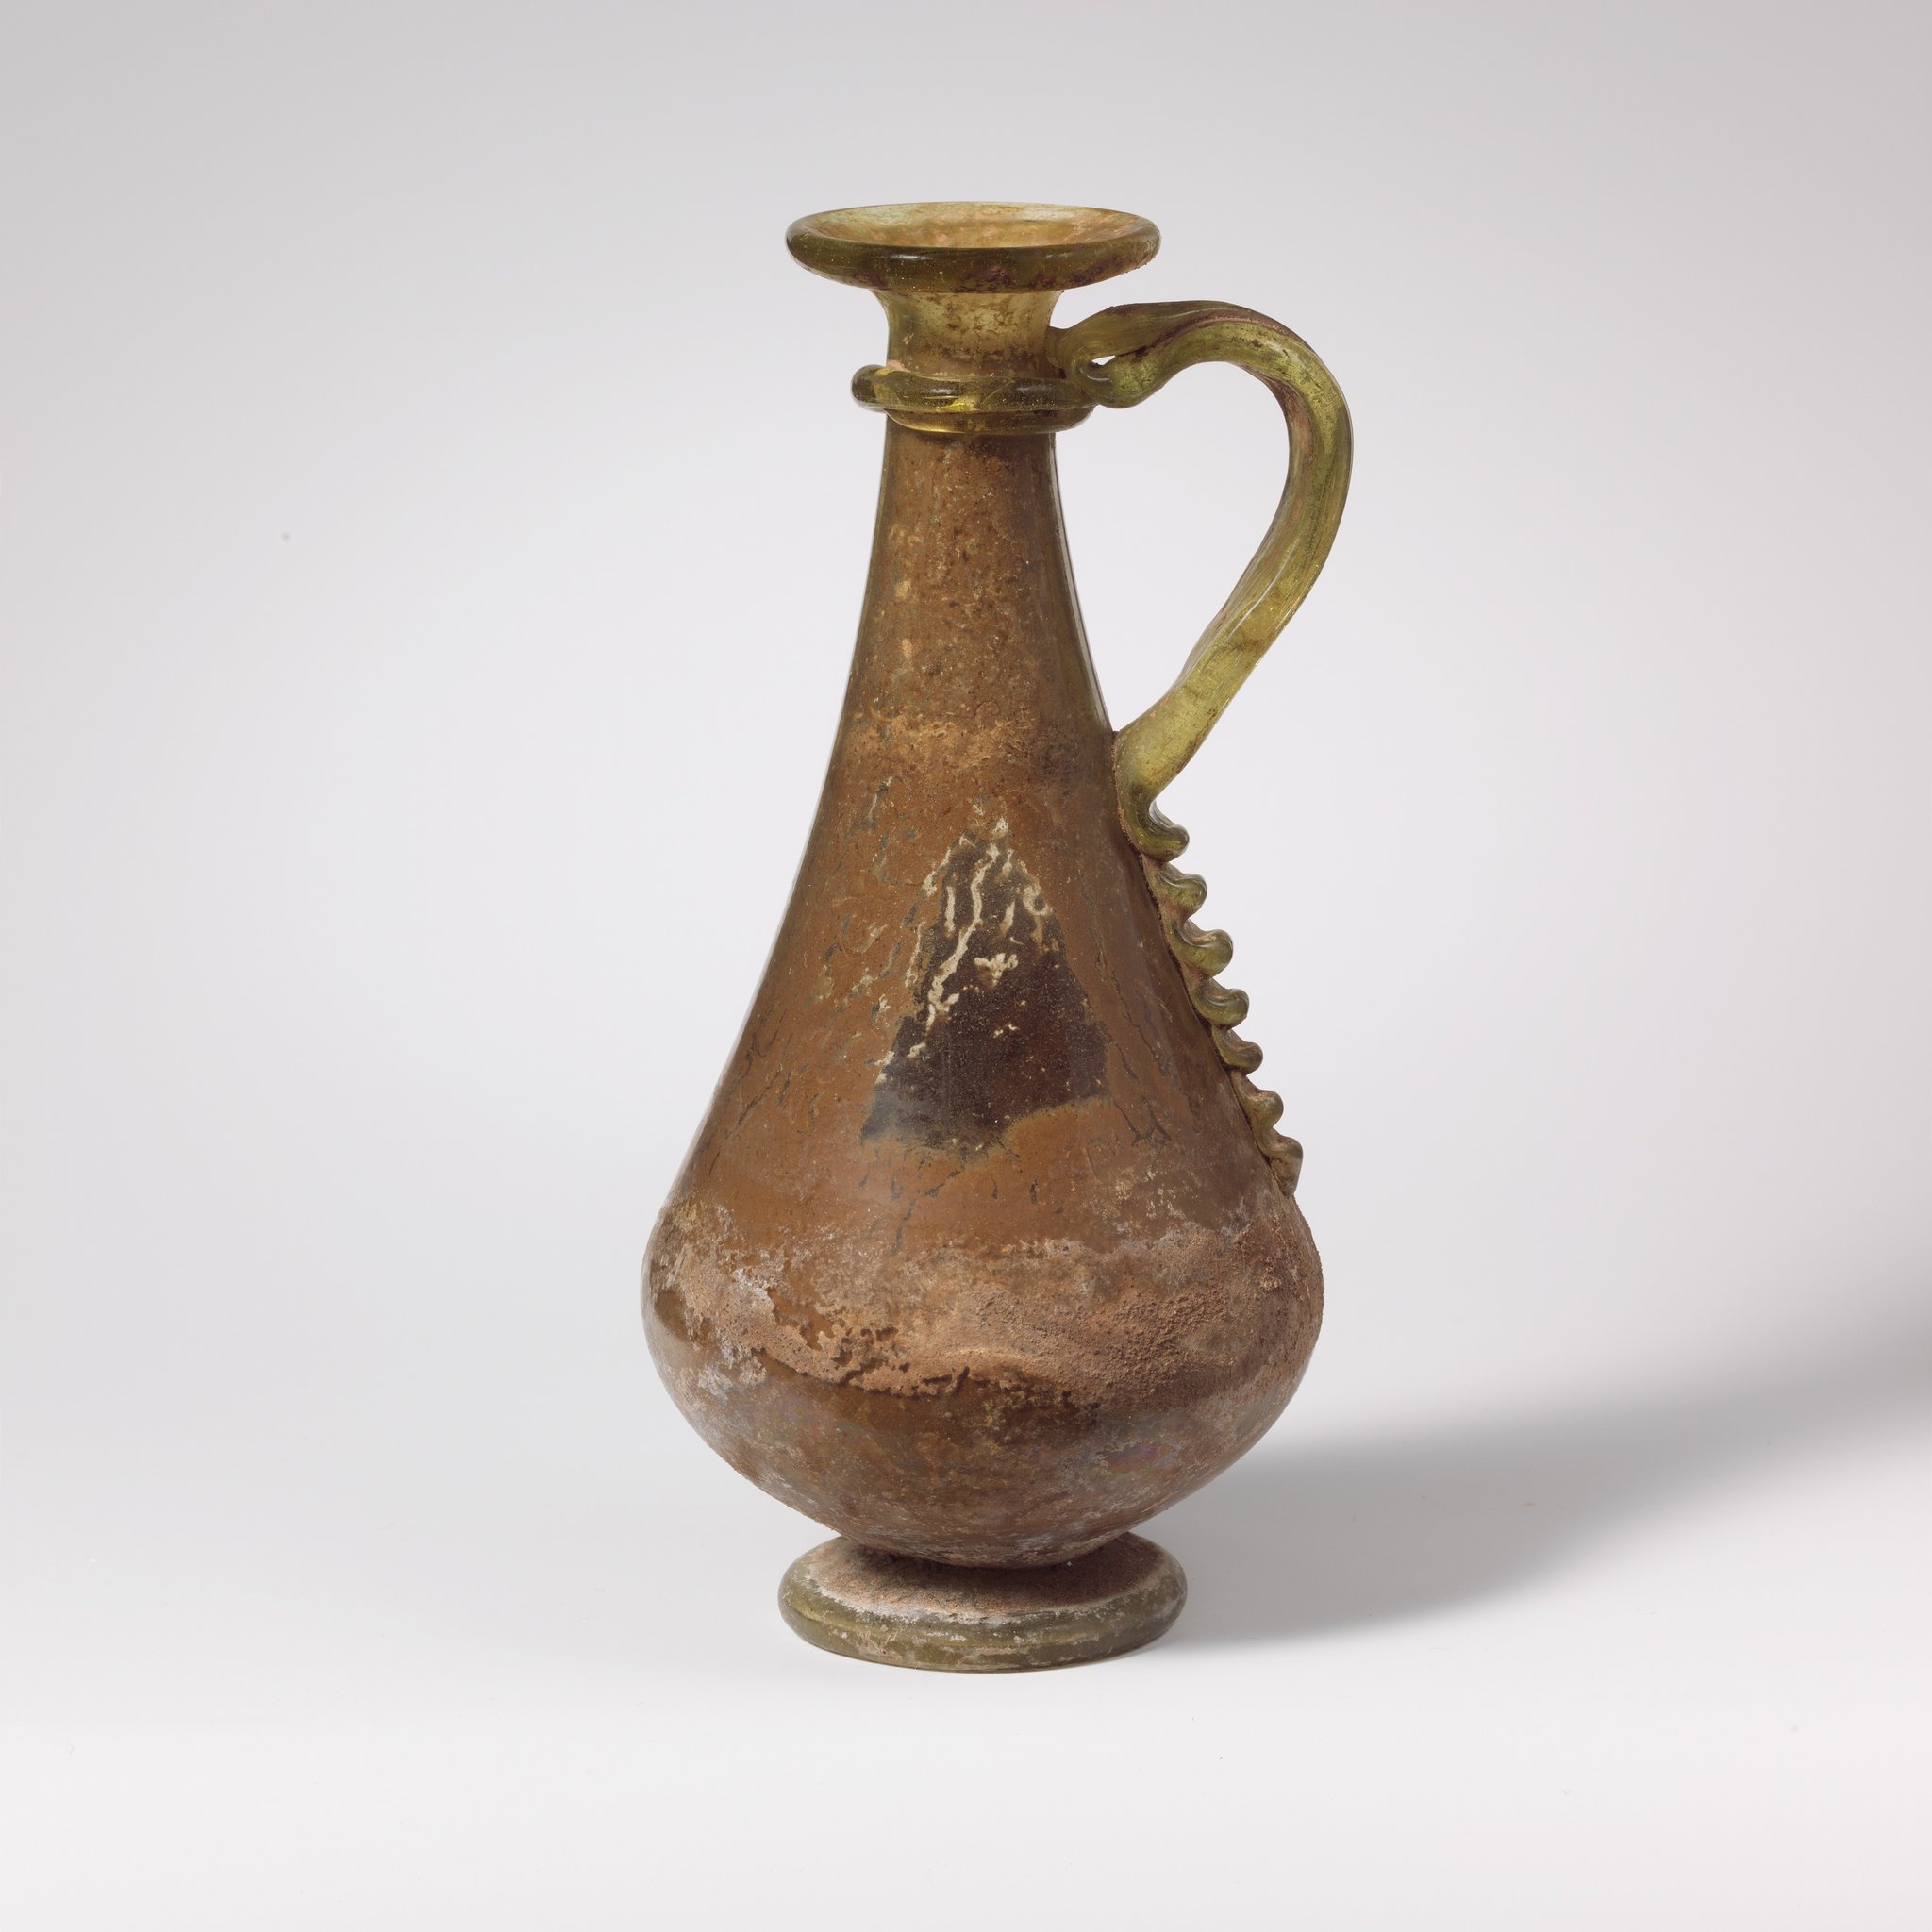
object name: jug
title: Glass jug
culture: roman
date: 301-400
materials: glass